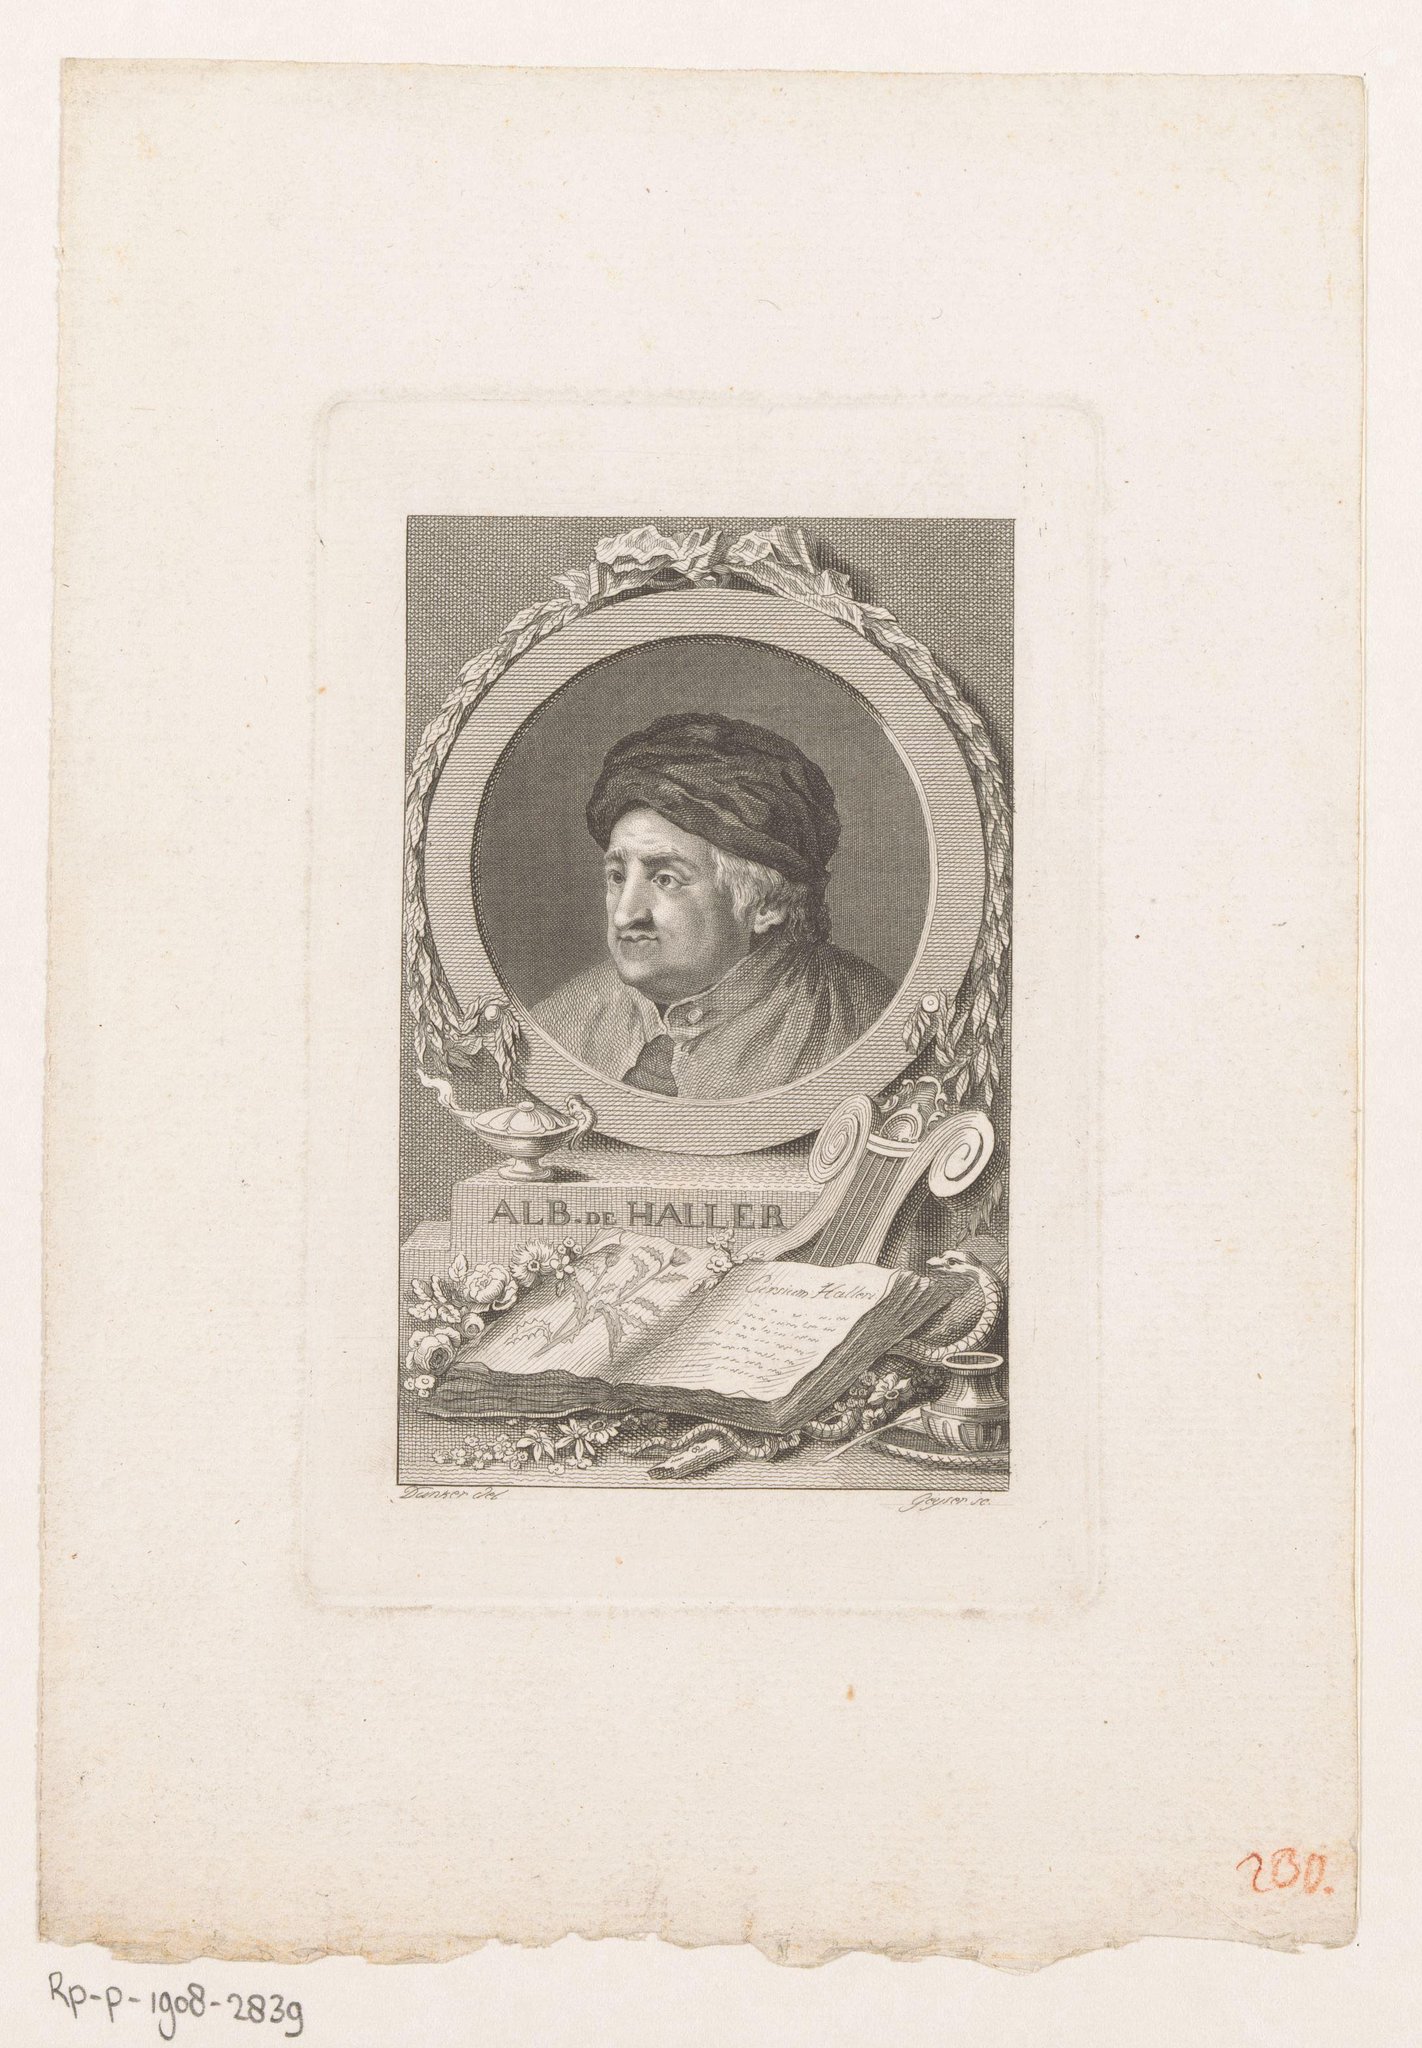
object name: print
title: Portret van Albrecht Haller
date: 1752-1803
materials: paper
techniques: engraving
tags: physicist, snakes, lyre, cithara, psaltery, historical persons, oil-lamp, writer, poet, author, botany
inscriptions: collector's mark: Lugt 2228